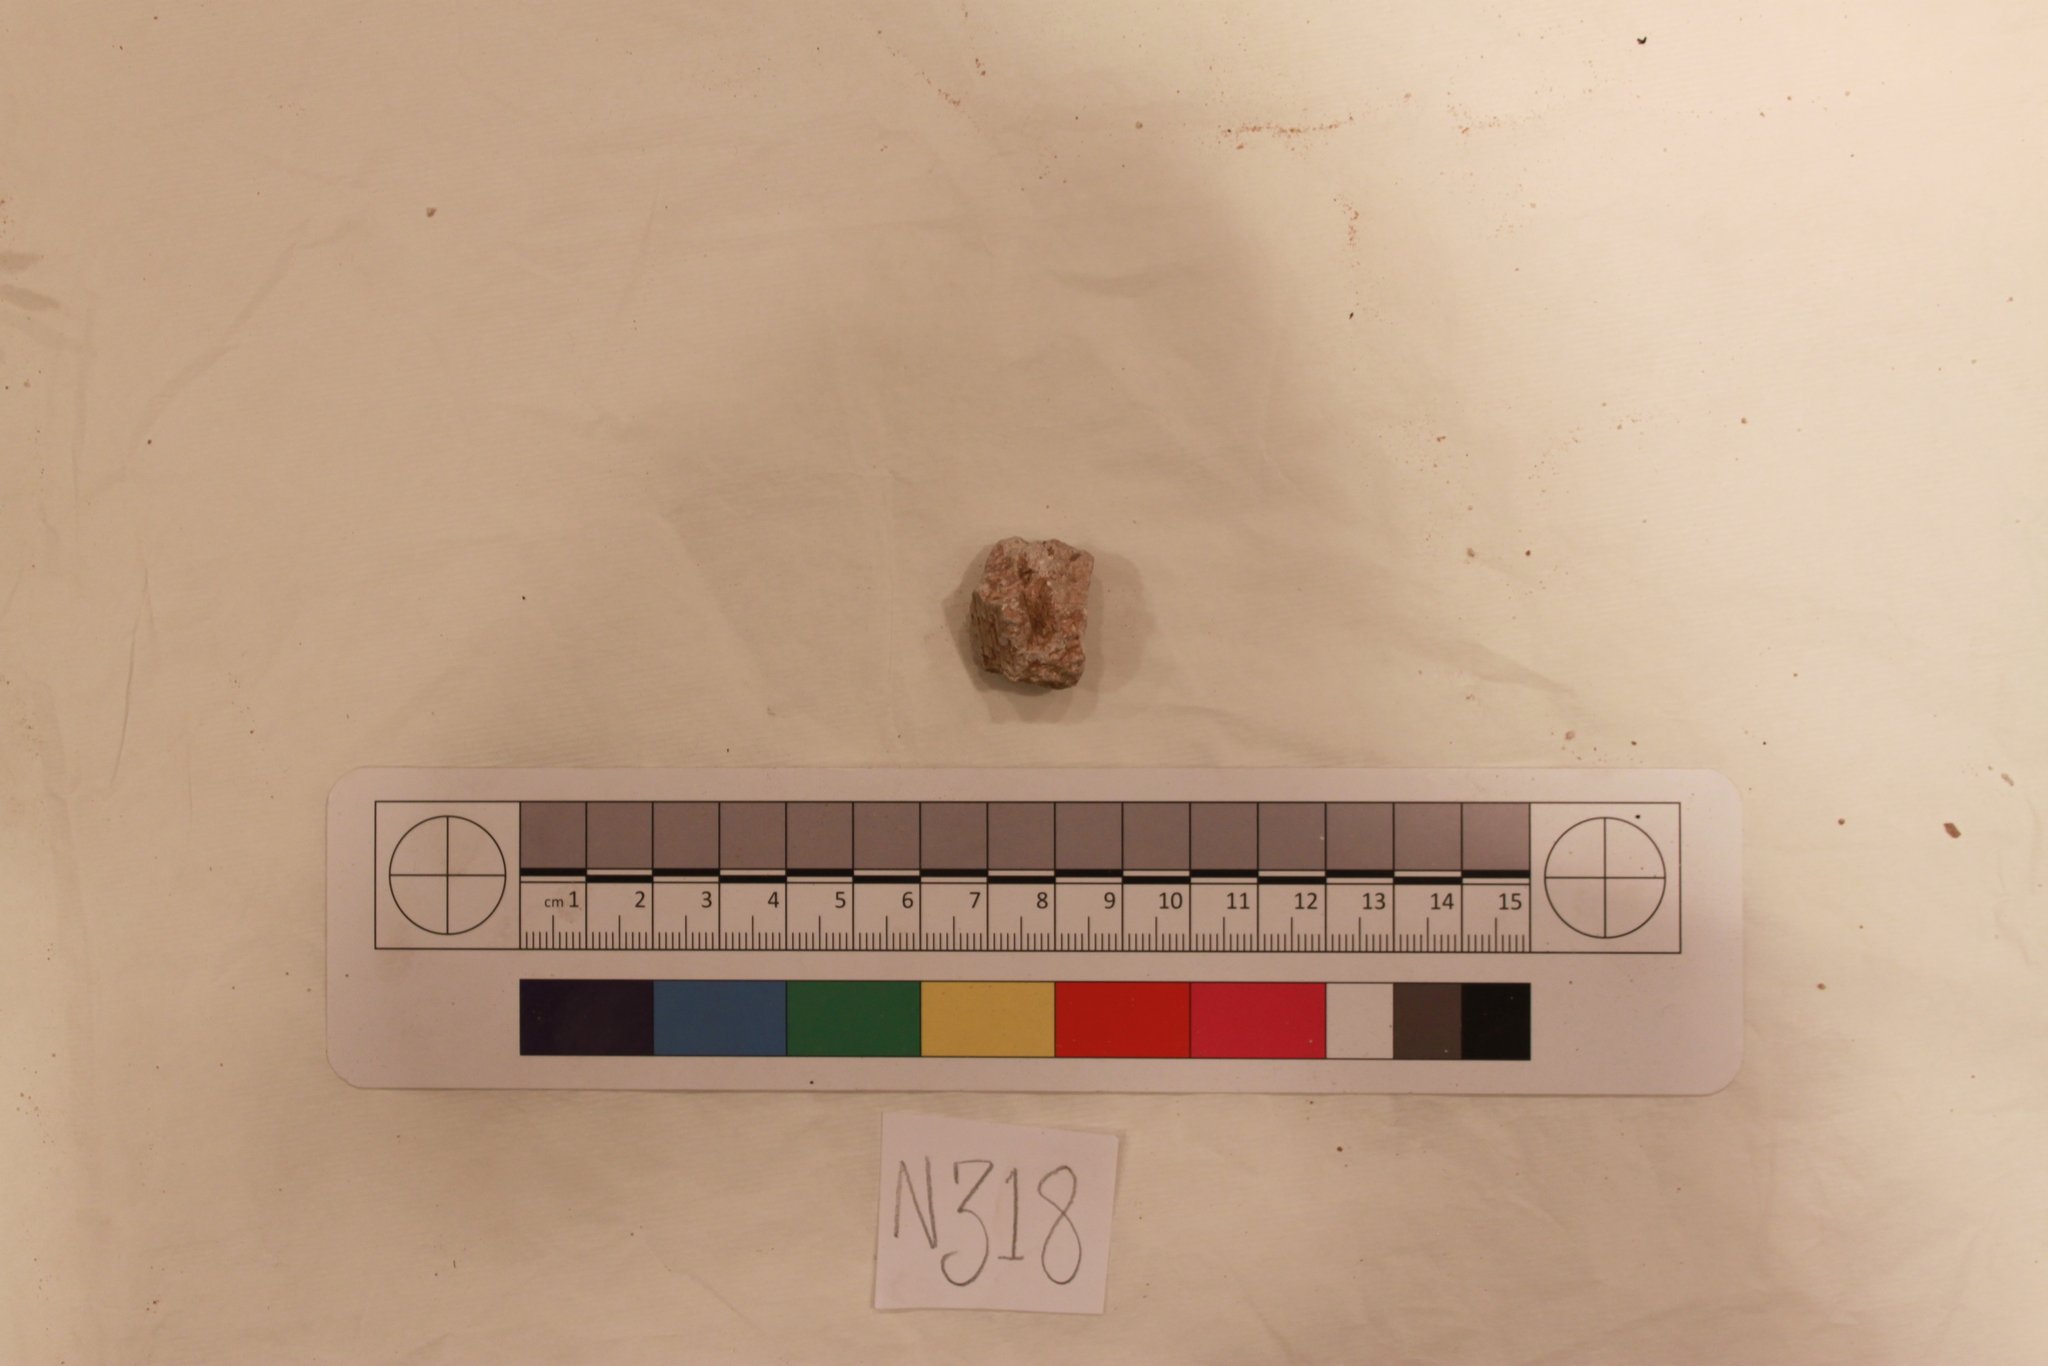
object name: fragment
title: Stucco Fragment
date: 701-1200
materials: plaster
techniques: carving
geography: iran